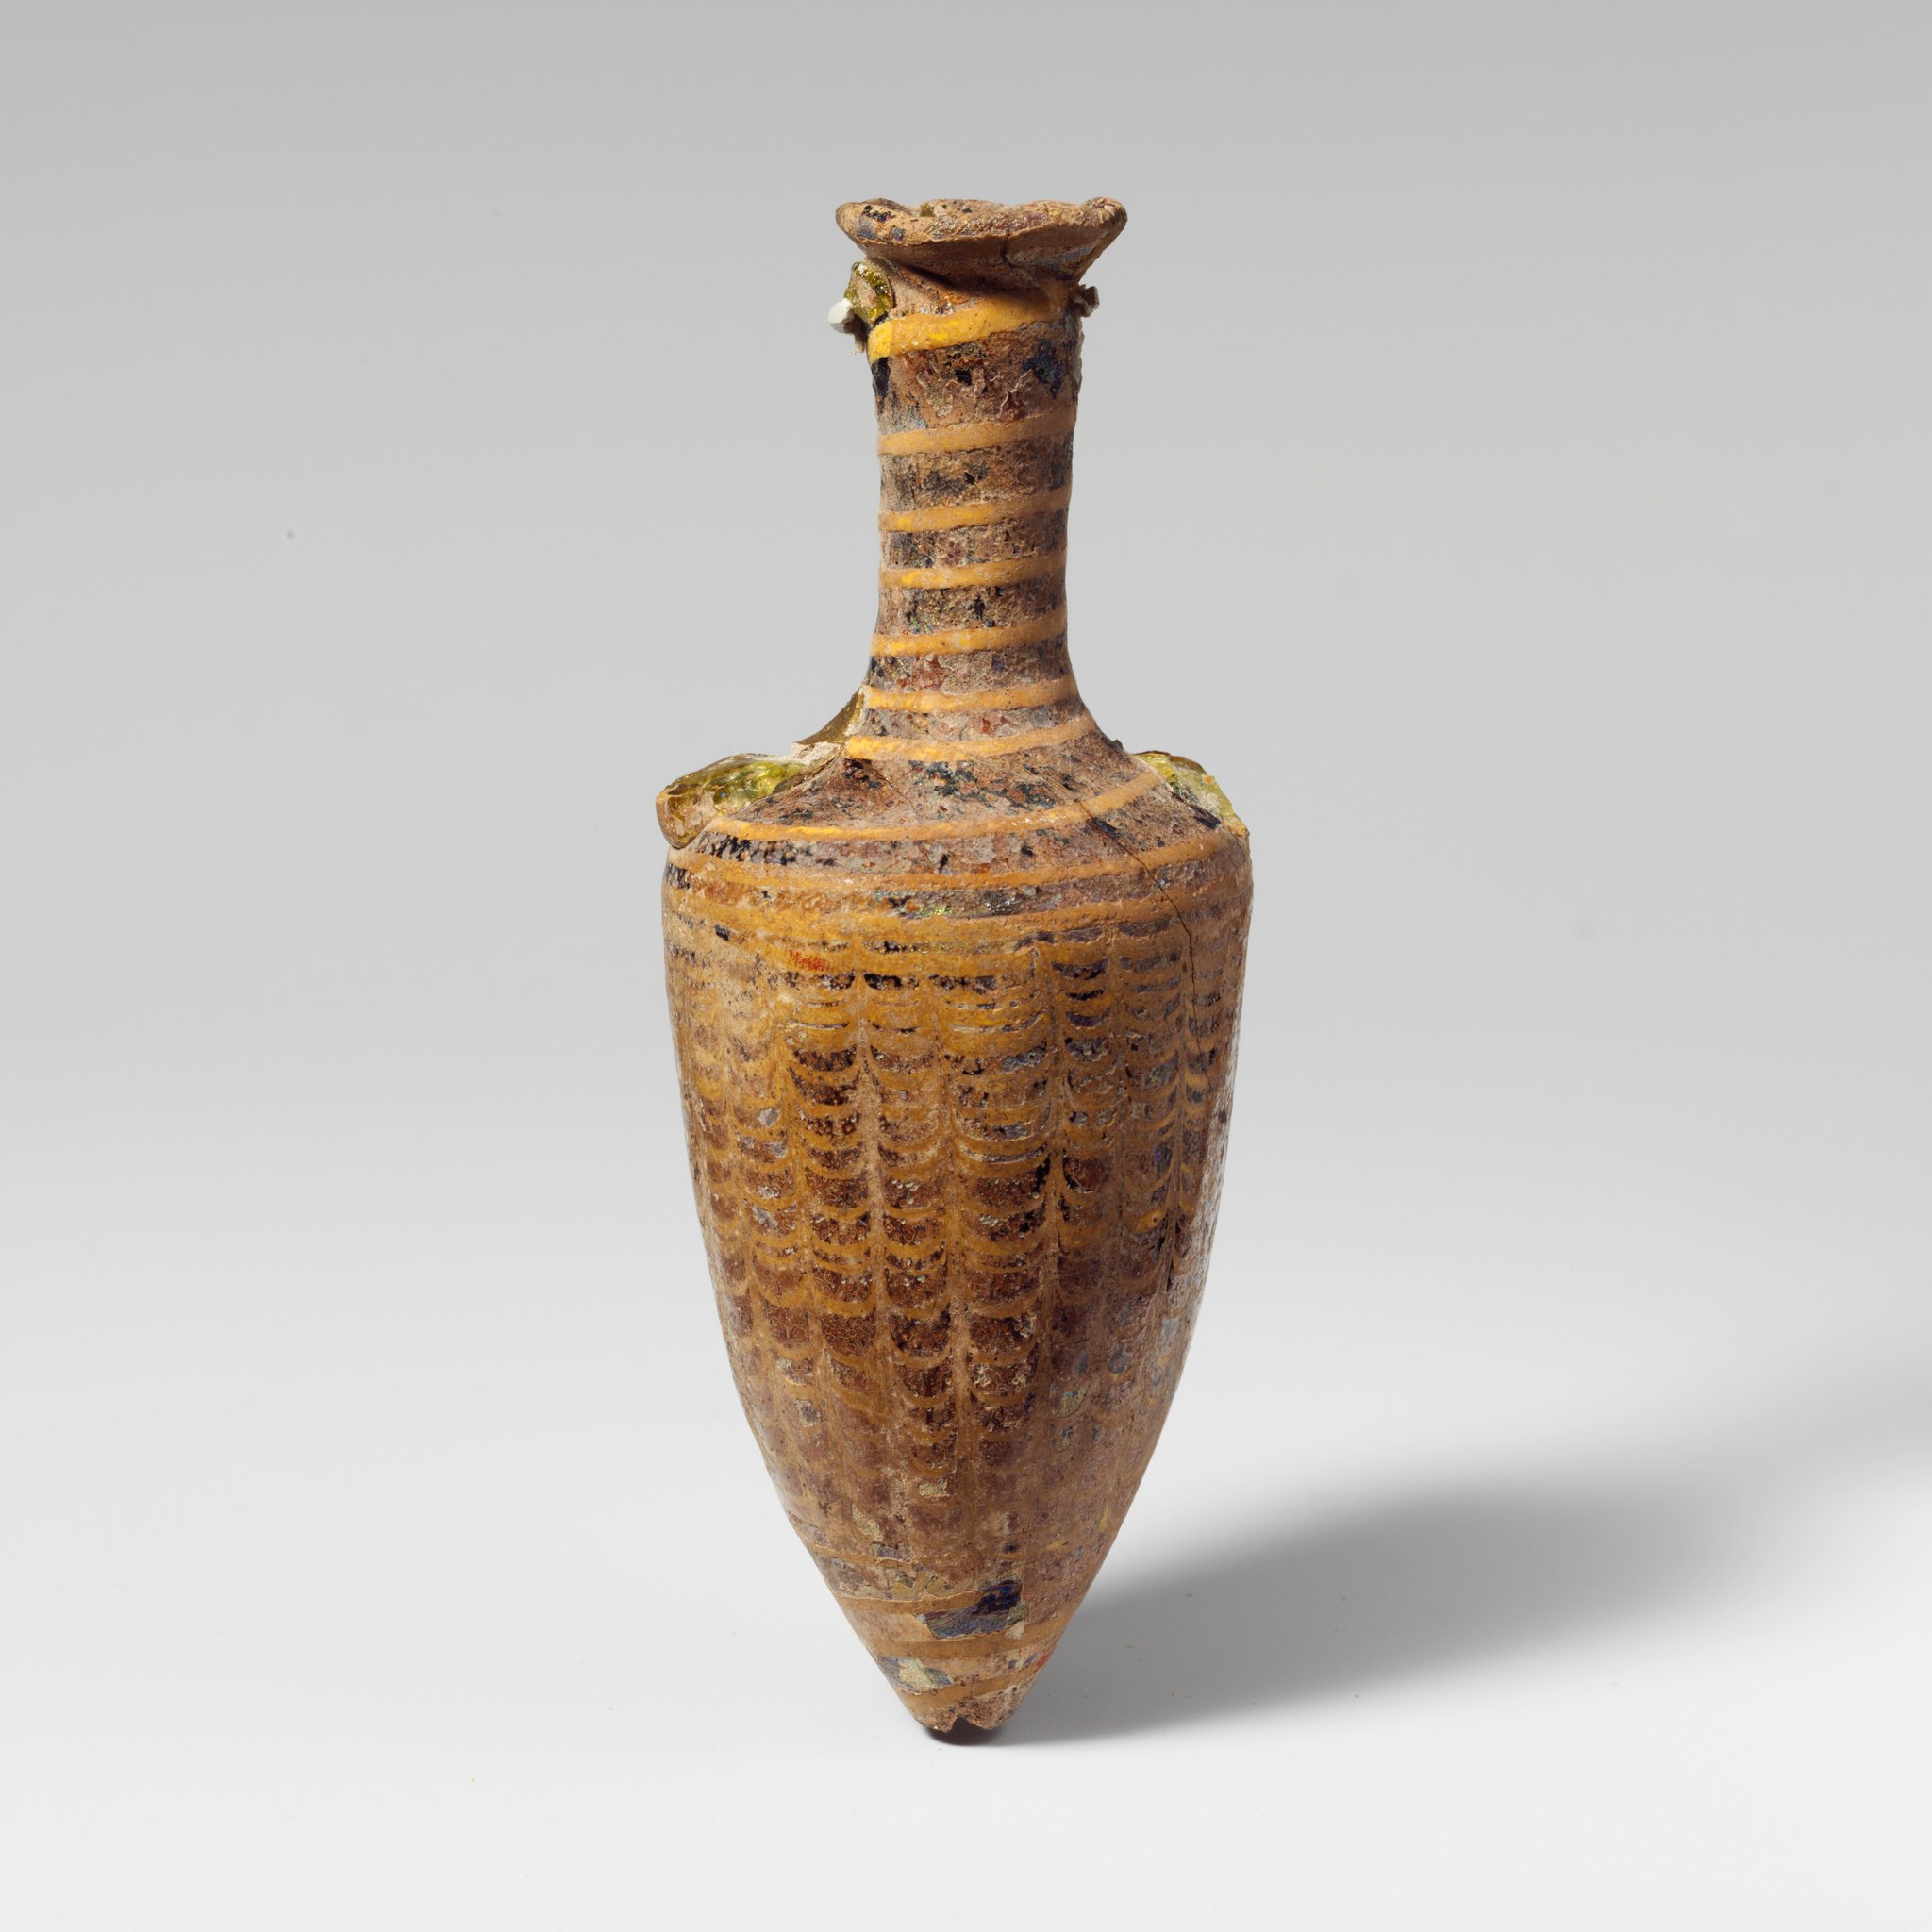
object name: amphoriskos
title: Glass amphoriskos (perfume bottle)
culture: greek, eastern mediterranean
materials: glass